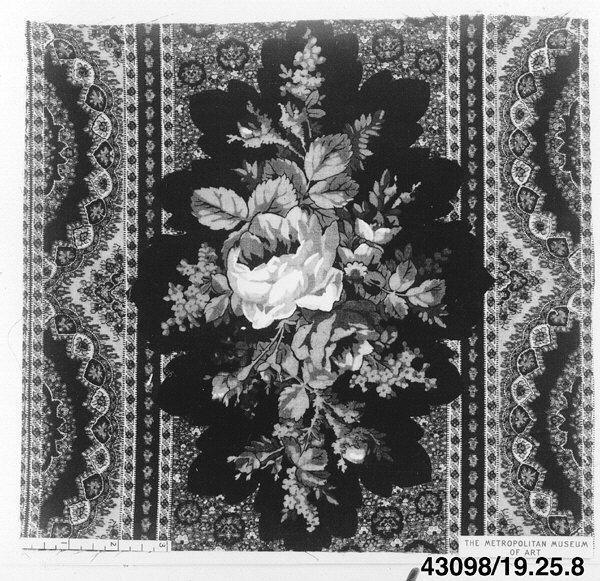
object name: sample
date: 1830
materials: wool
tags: flowers